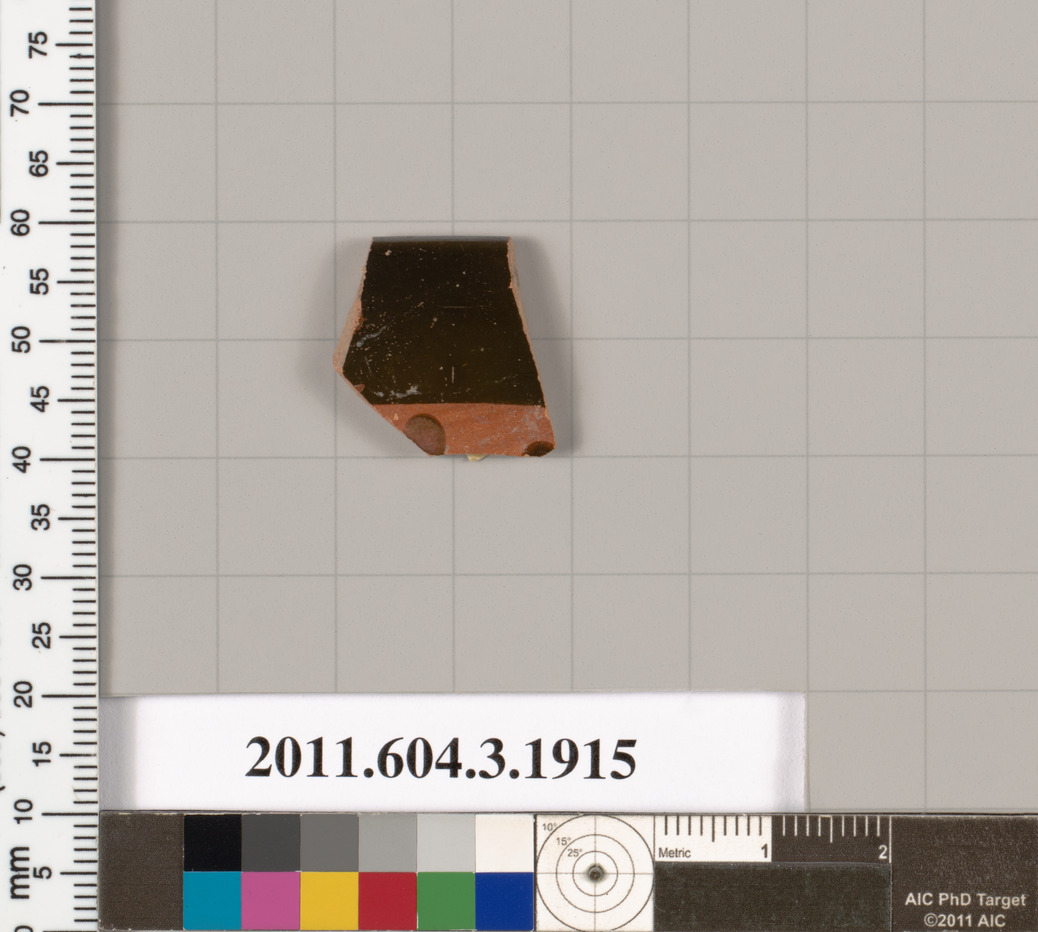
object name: kylix or skyphos fragment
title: Terracotta fragment of a kylix (drinking cup) or a skyphos (deep drinking cup)?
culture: greek, attic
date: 525-501 BCE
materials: terracotta